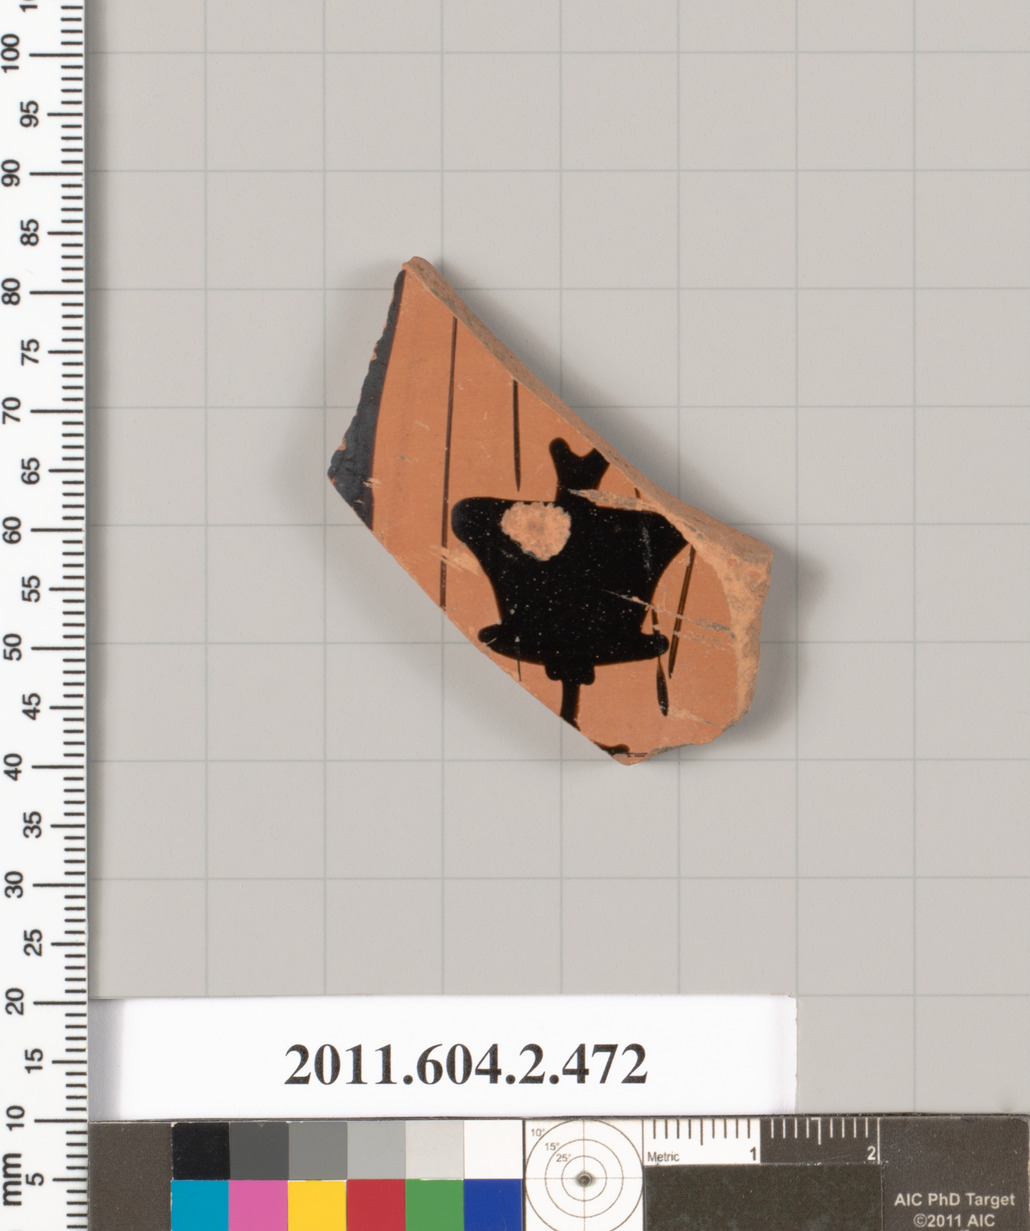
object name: column krater fragment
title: Terracotta fragment of a column-krater (bowl for mixing wine and water)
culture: greek, attic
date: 475-451 BCE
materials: terracotta